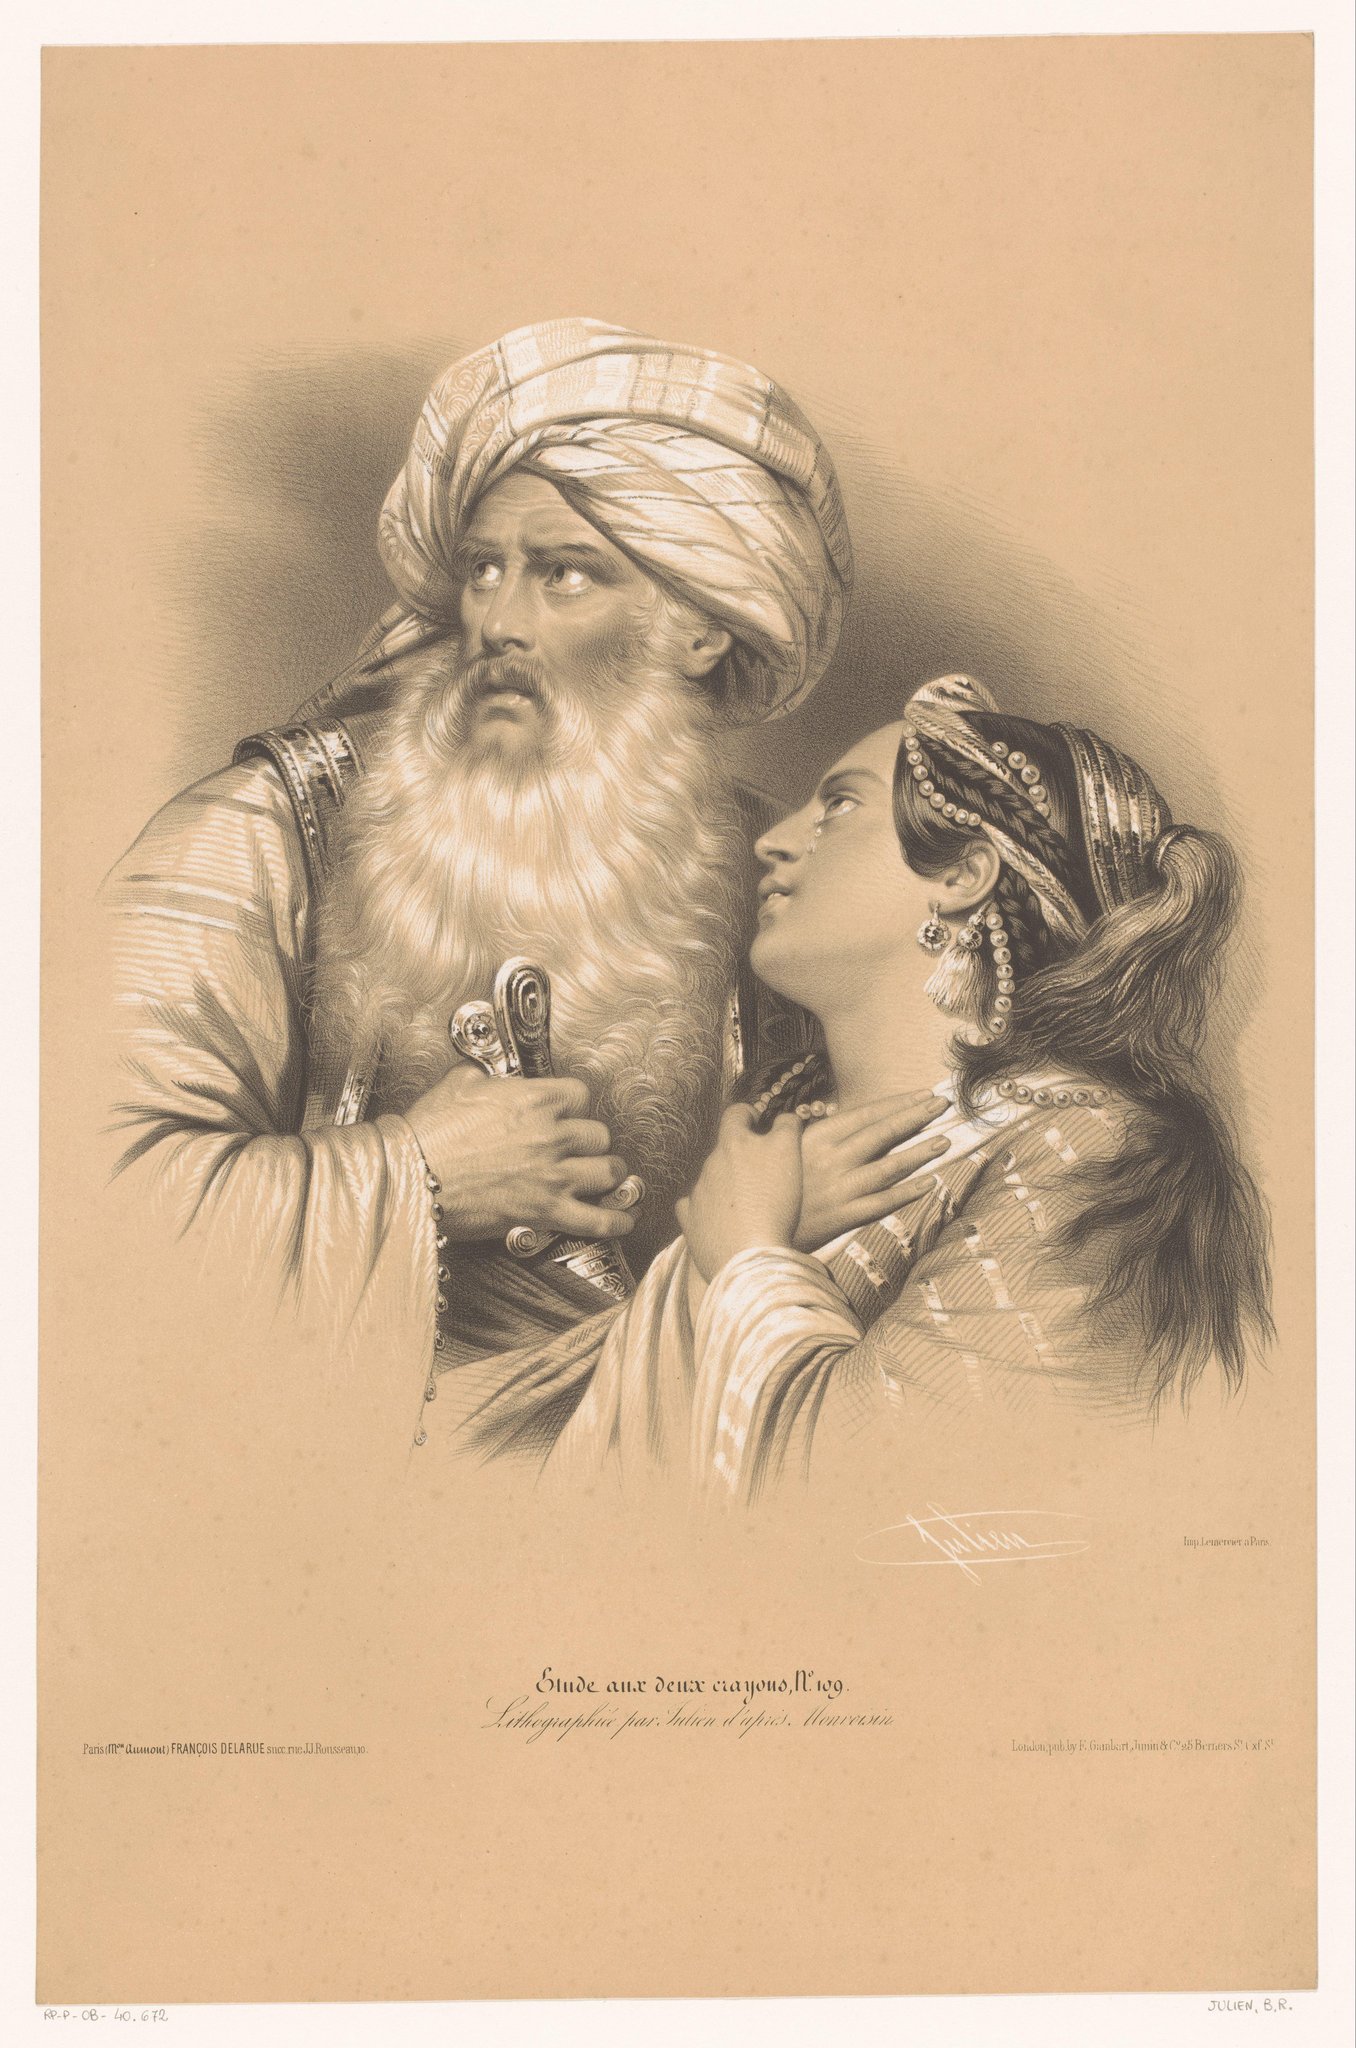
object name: print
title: Étude aux deux Crayons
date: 1848-1853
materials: paper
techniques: tone lithography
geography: london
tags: father with daughter(s) (father-love), head-gear: turban, weeping, suicide out of despair